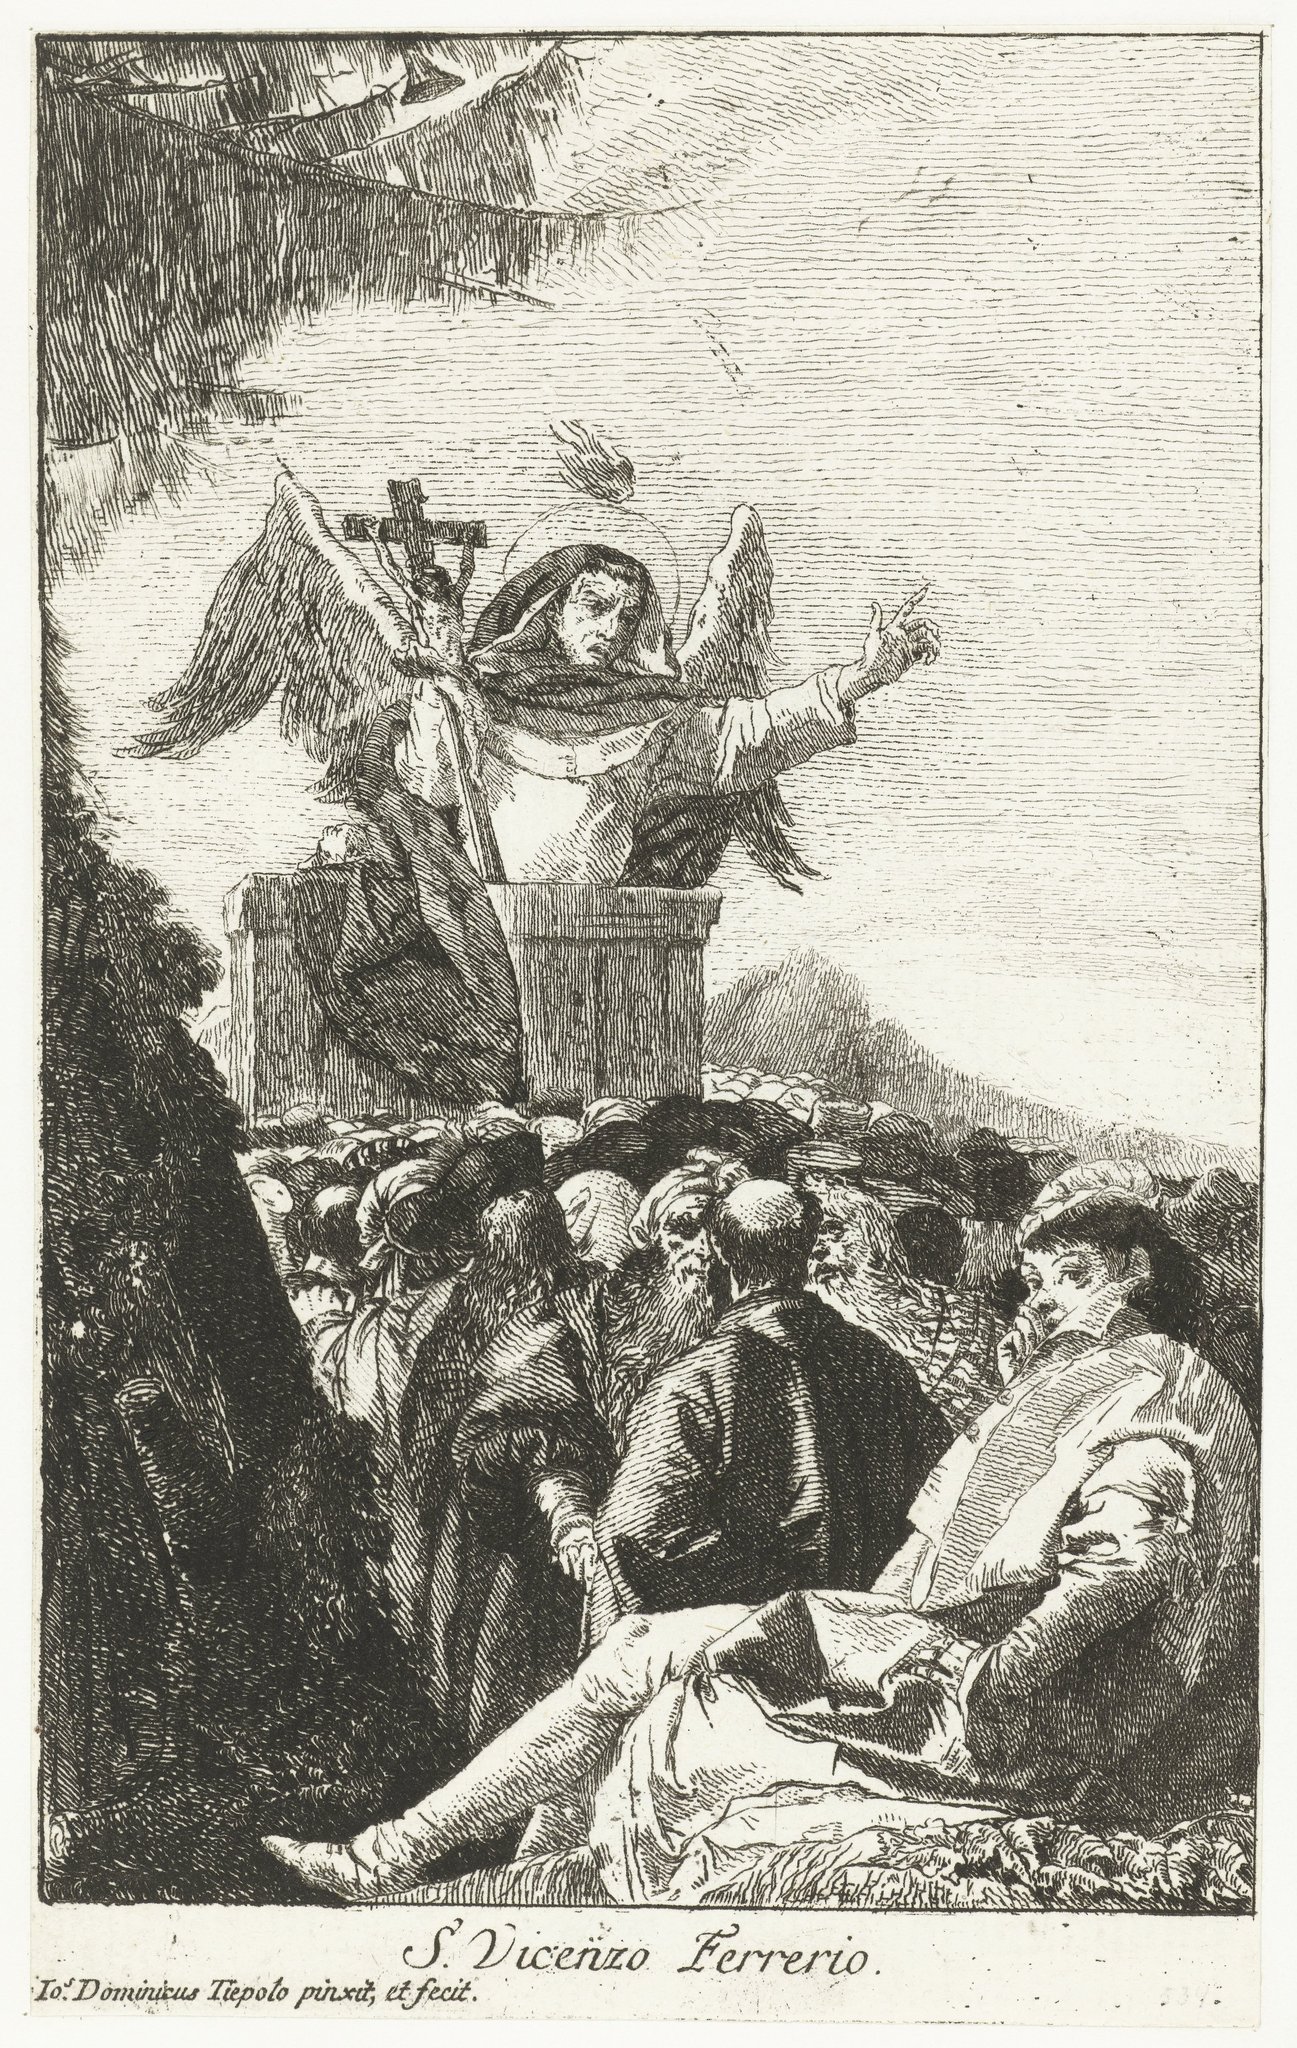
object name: print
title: S. Vicenzo Ferrerio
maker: giovanni domenico tiepolo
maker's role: draughtsman, print maker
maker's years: 1727-1804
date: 1748-1752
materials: paper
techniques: etching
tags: the dominican friar vincent ferrer of valencia (or vannes); possible attributes: book, baptismal font, cardinal's hat at feet, flames, flaming sword, ihs monogram, lily, sun, trumpet of the last judgement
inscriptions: collector's mark: Lugt 2760, collector's mark: Lugt 2228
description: Prent gebaseerd op schilderij vervaardigd voor Oratorio del Crocifisso in kerk S. Polo, Venetië.